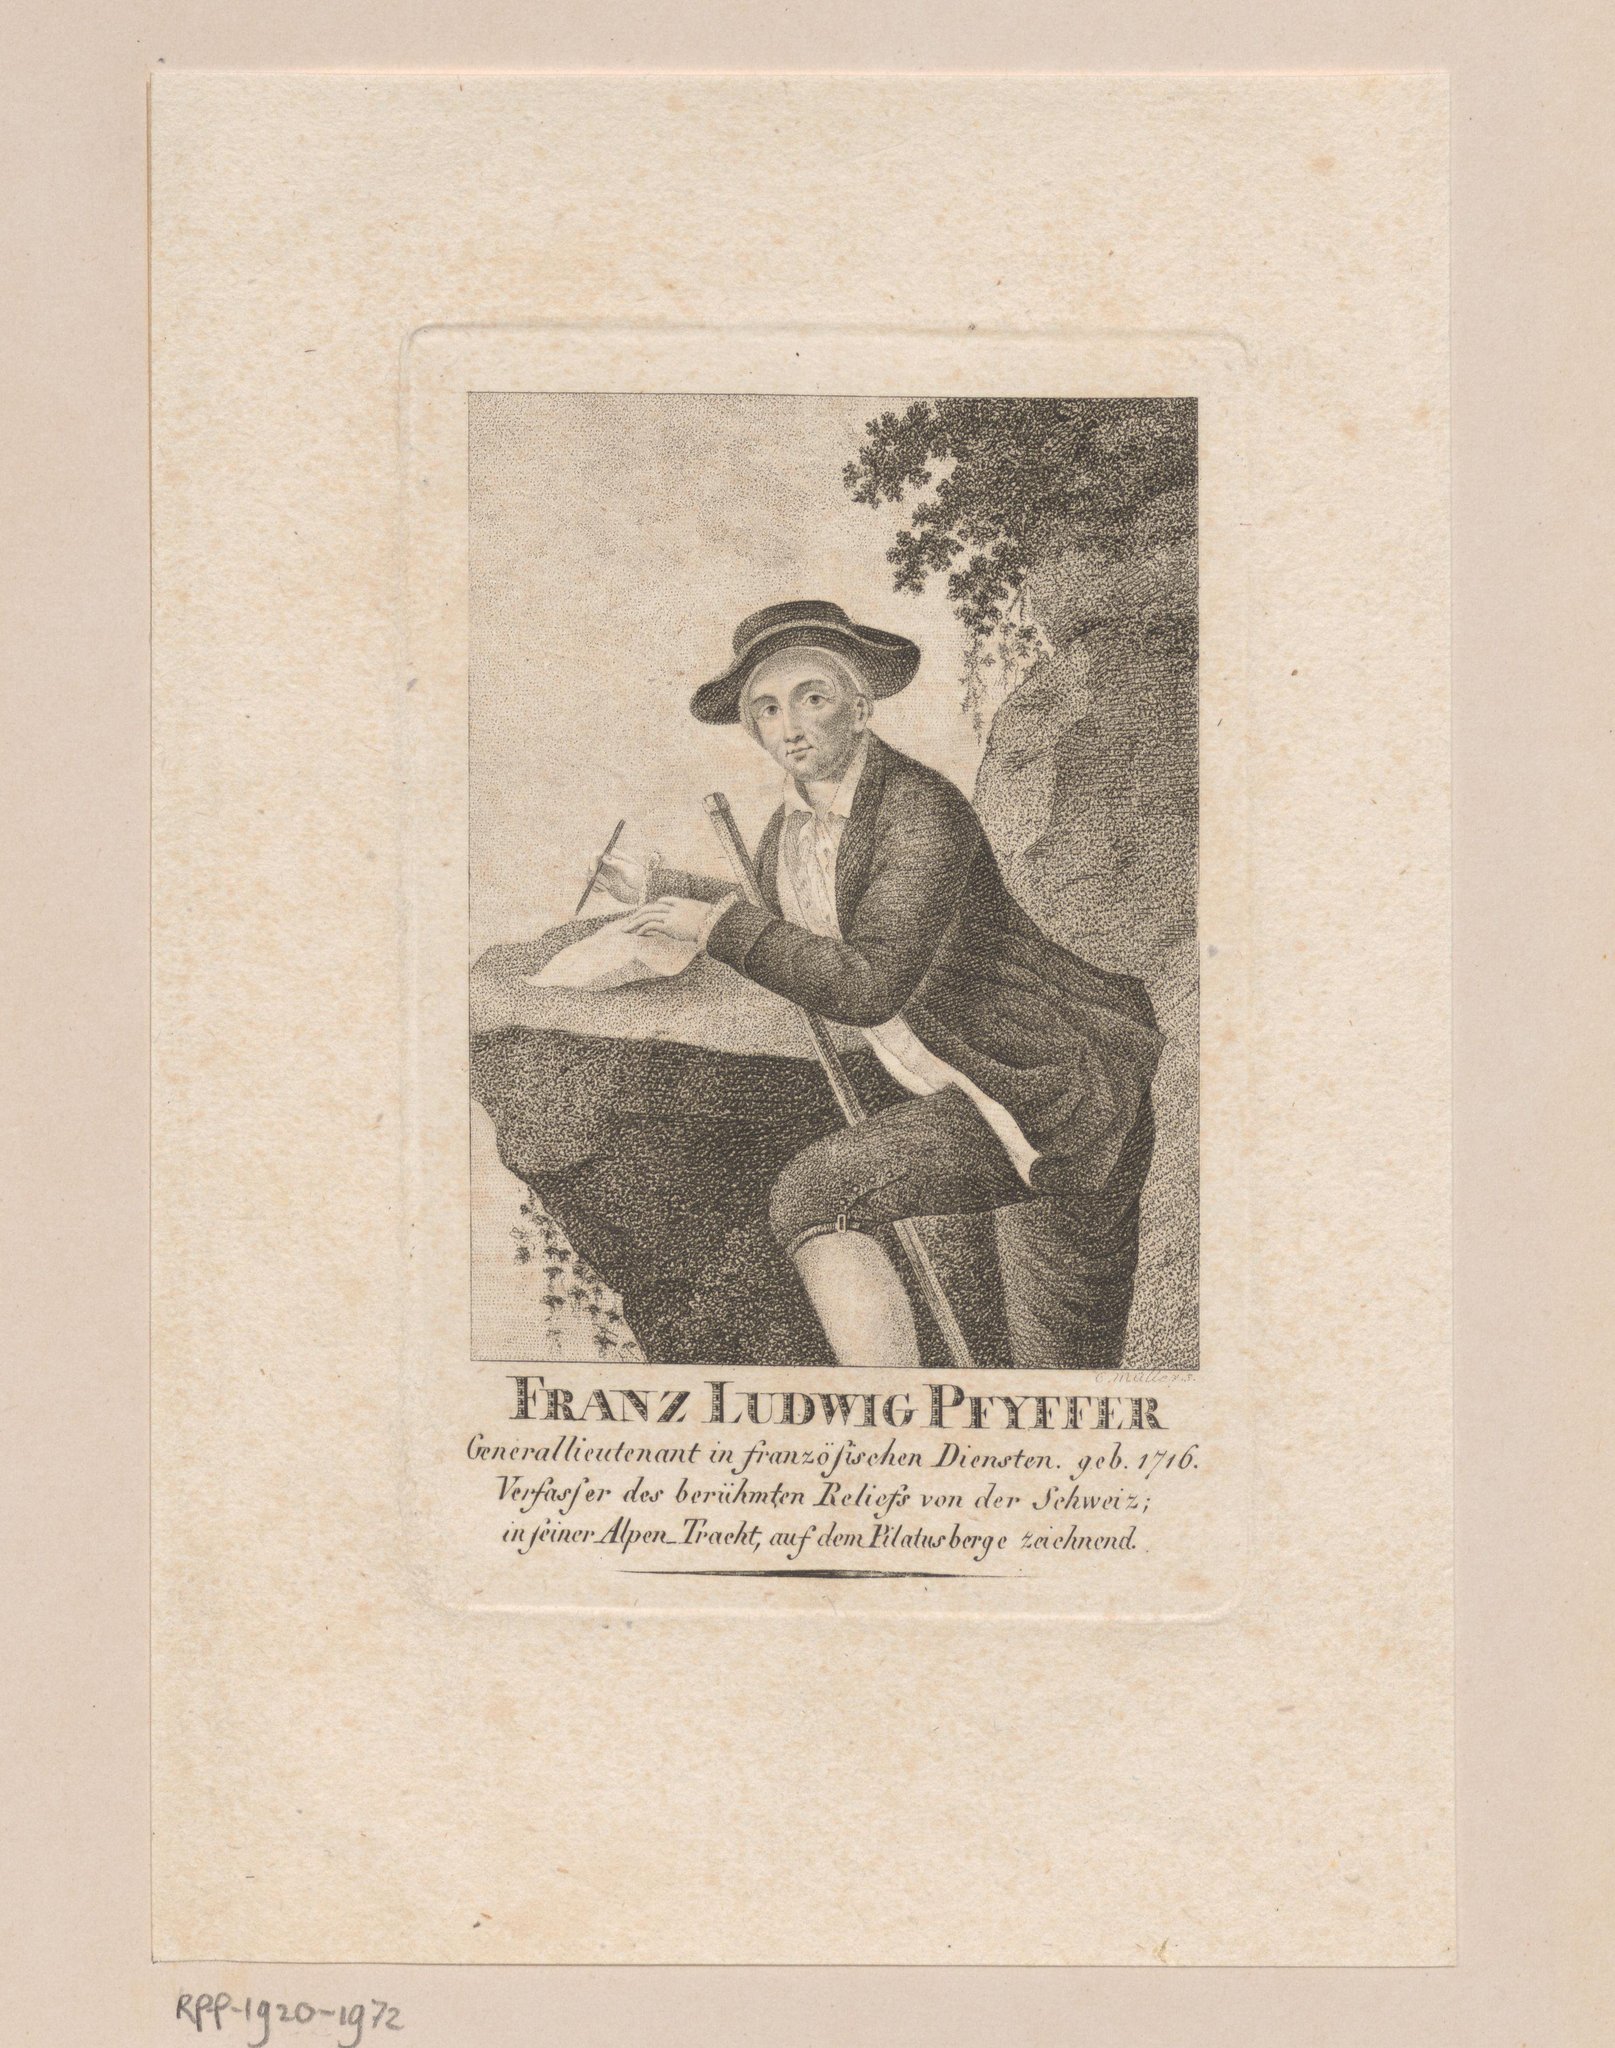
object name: print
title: Portret van Franz Ludwig Pfyffer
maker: c. müller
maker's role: print maker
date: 1806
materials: paper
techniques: engraving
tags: historical persons, writing and letters, rocks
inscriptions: collector's mark: Lugt 2228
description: Prent mogelijk uit: Bertuch, Friedrich Justin. Allgemeine geographische Ephemeriden: Mit Kupfern und Charten. Weimar: Industrie-Comptoir, 1806, dl. 19.